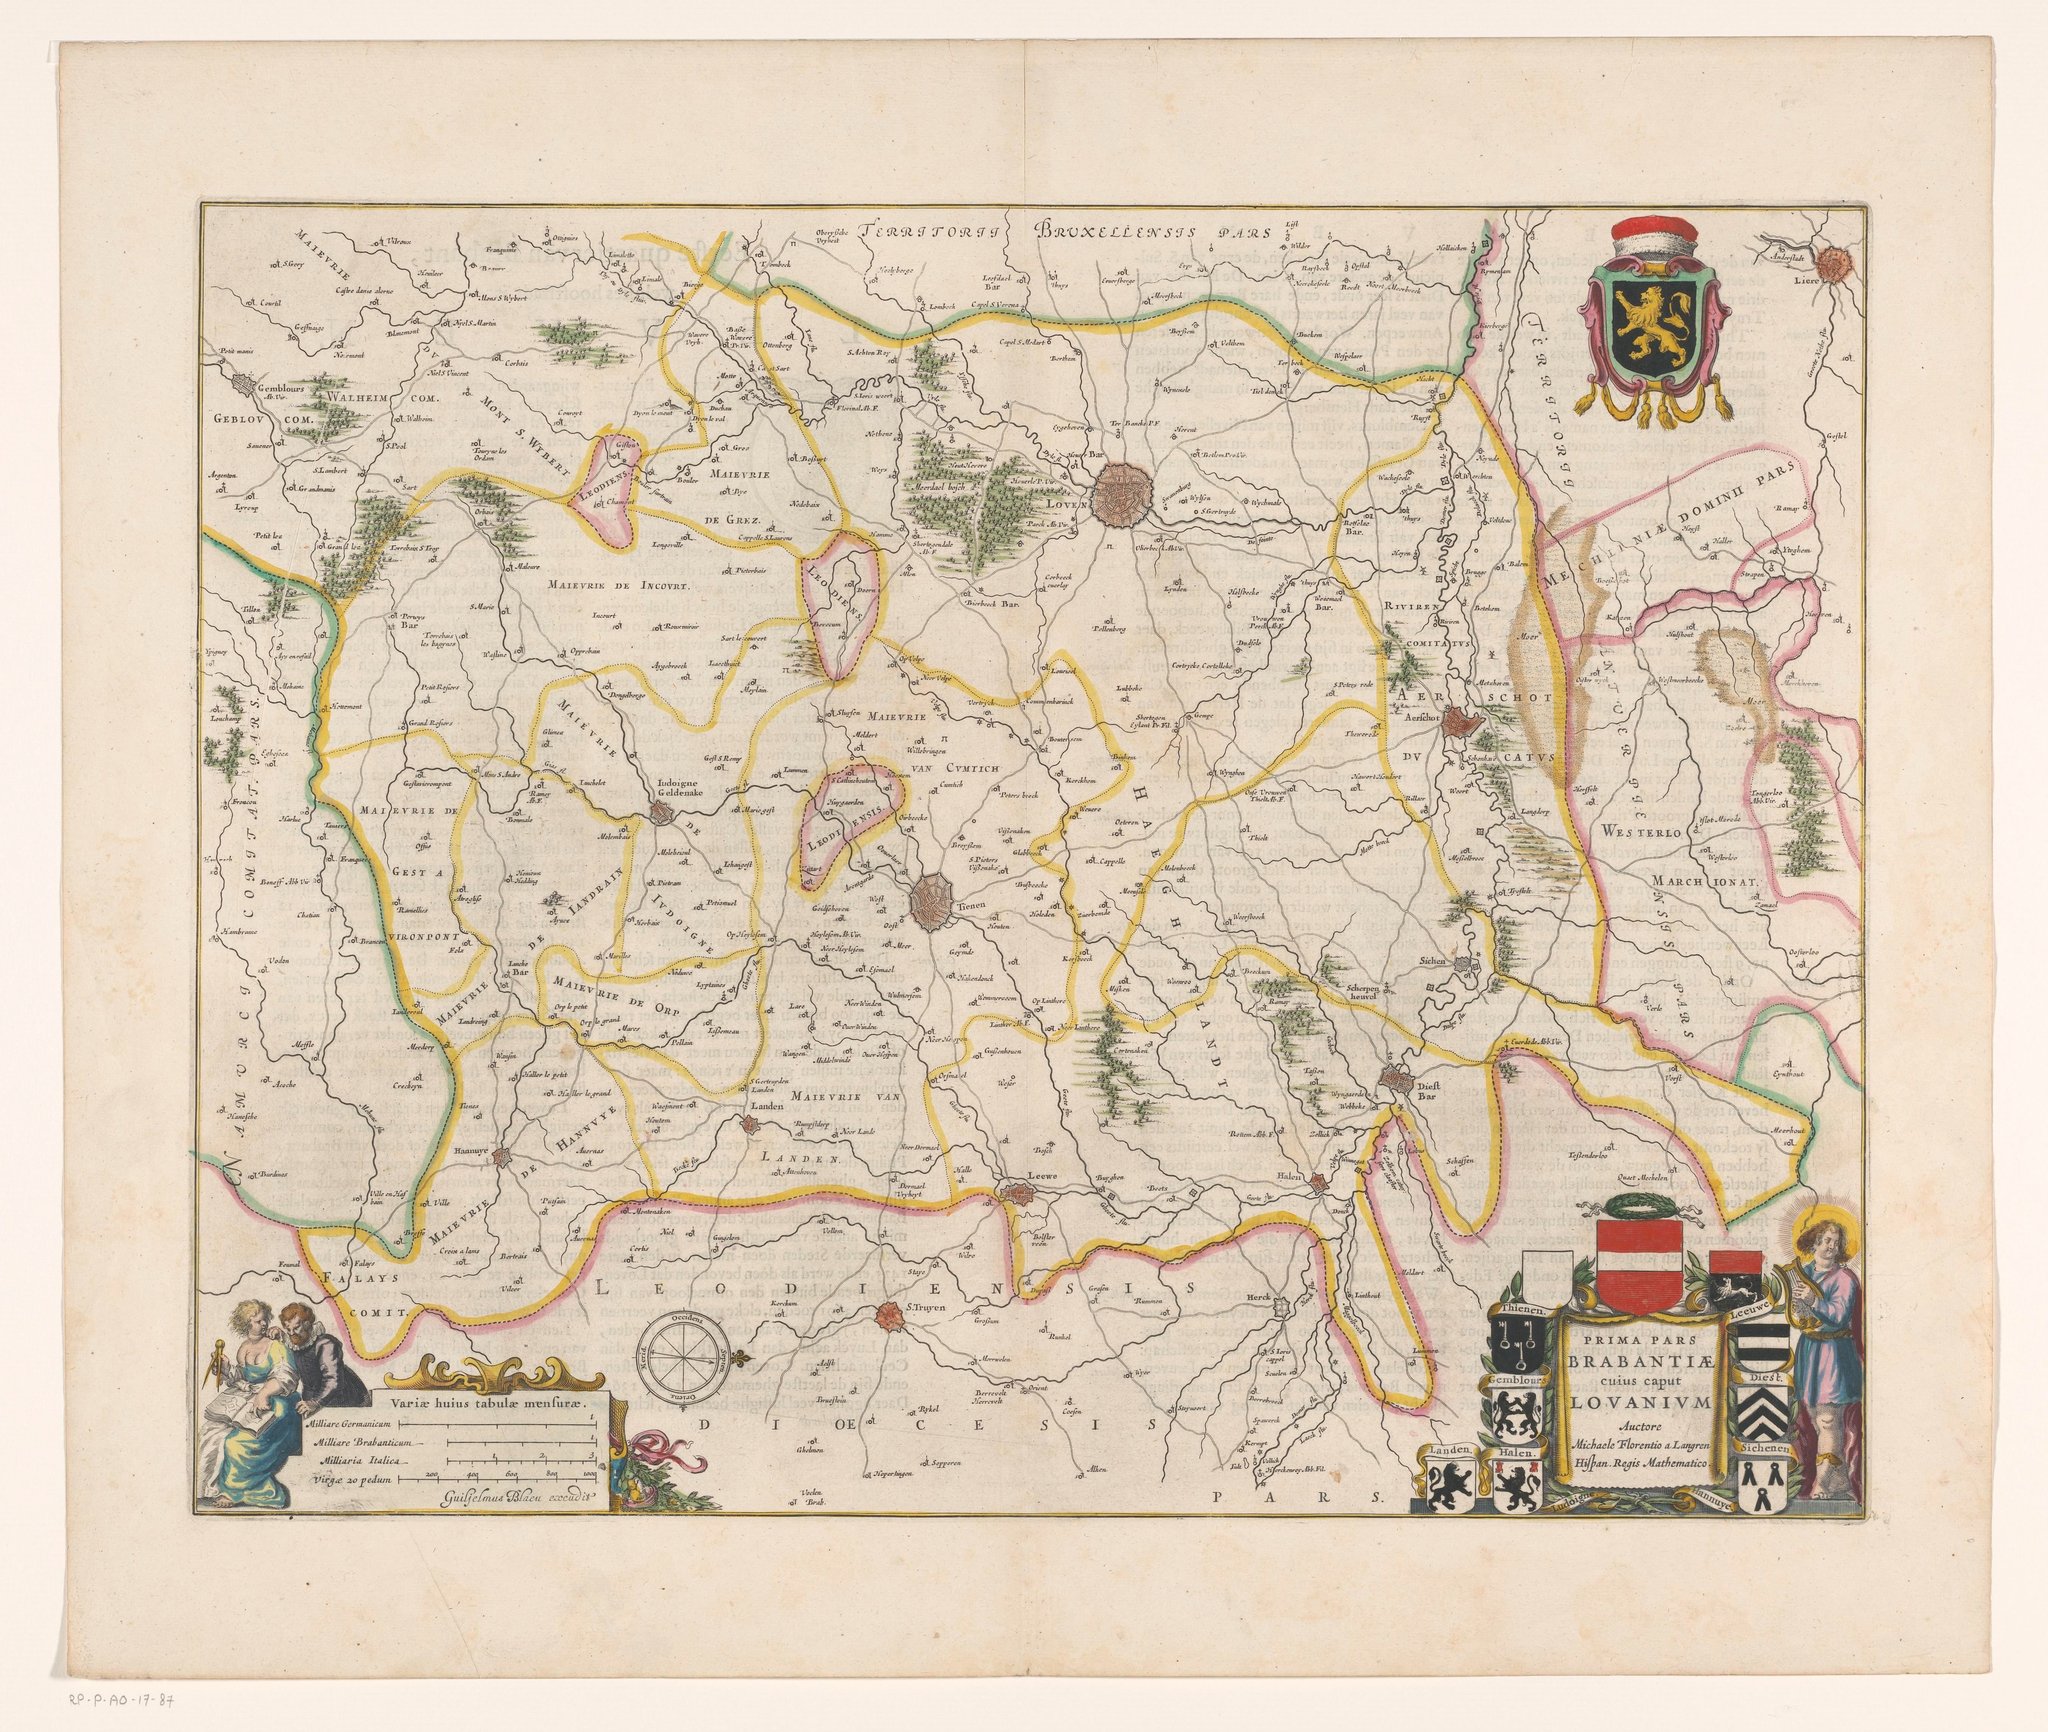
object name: print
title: Prima pars Brabantiae cuius caput Lovanium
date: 1642-1664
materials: paper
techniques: engraving, etching, hand coloring, letterpress printing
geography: amsterdam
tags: coat of arms (as symbol of the state, etc.) (+ city; municipal), maps of separate countries or regions, coat of arms (as symbol of the state, etc.) (+ province; provincial), brabant, louvain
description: Huidige staat van prent gebruikt in: Blaeu, Willem Janszoon en Johannes Willemszoon Blaeu. Toonneel des aerdriicx, ofte nieuwe Atlas, dat is de beschryving van alle landen. 3 delen. Amsterdam: Johannes Willemszoon Blaeu, 1642-1643, dl. 1 (1642). Of in: Blaeu, Willem Janszoon en Johannes Willemszoon Blaeu. Toonneel des aerdrycx, ofte nieuwe Atlas, dat is de beschryving van alle landen. 4 delen. Amsterdam: Johannes Willemszoon Blaeu, 1647-1650, dl. 1 (1647-1648). Of in: Blaeu, Willem Janszoon en Johannes Willemszoon Blaeu. Toonneel des aerdrycx, ofte nieuwe Atlas, dat is de beschryving van alle landen. 4 delen. Amsterdam: Johannes Willemszoon Blaeu, 1649-1650, dl. 1 (1649). Of in: Blaeu, Willem Janszoon en Johannes Willemszoon Blaeu. Toonneel des aerdriicx, ofte niuew Atlas, dat is beschryving van alle landen. 6 delen. Amsterdam: Johannes Willemszoon Blaeu, 1658-1661, dl. 1. Of in: Blaeu, Johannes Willemszoon. J. Blaeus grooten atlas oft wereltbeschyving, in welcke 't aerdryck, de zee, en hemel, wort vertoont en beschreven. 9 delen. Amsterdam: Johannes Willlemszoon Blaeu, 1664-1665, dl. 3 (1664).